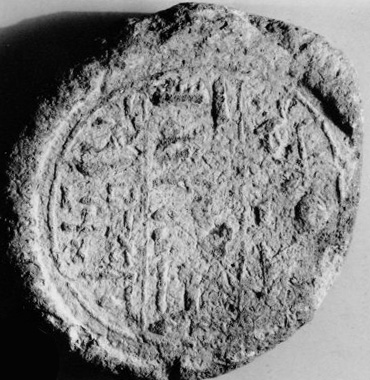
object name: cone, circular impression, nakht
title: Funerary Cone of Nakht and His Wife Senhotep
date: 1479-1458 BCE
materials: pottery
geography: egypt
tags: hieroglyphs